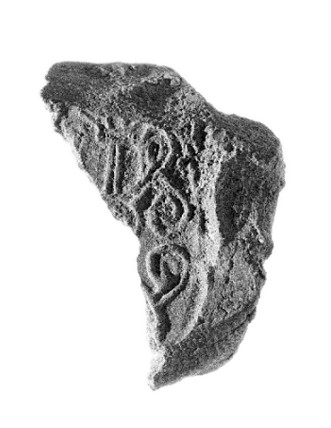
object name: sealing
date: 1981-1640 BCE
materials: mud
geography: egypt